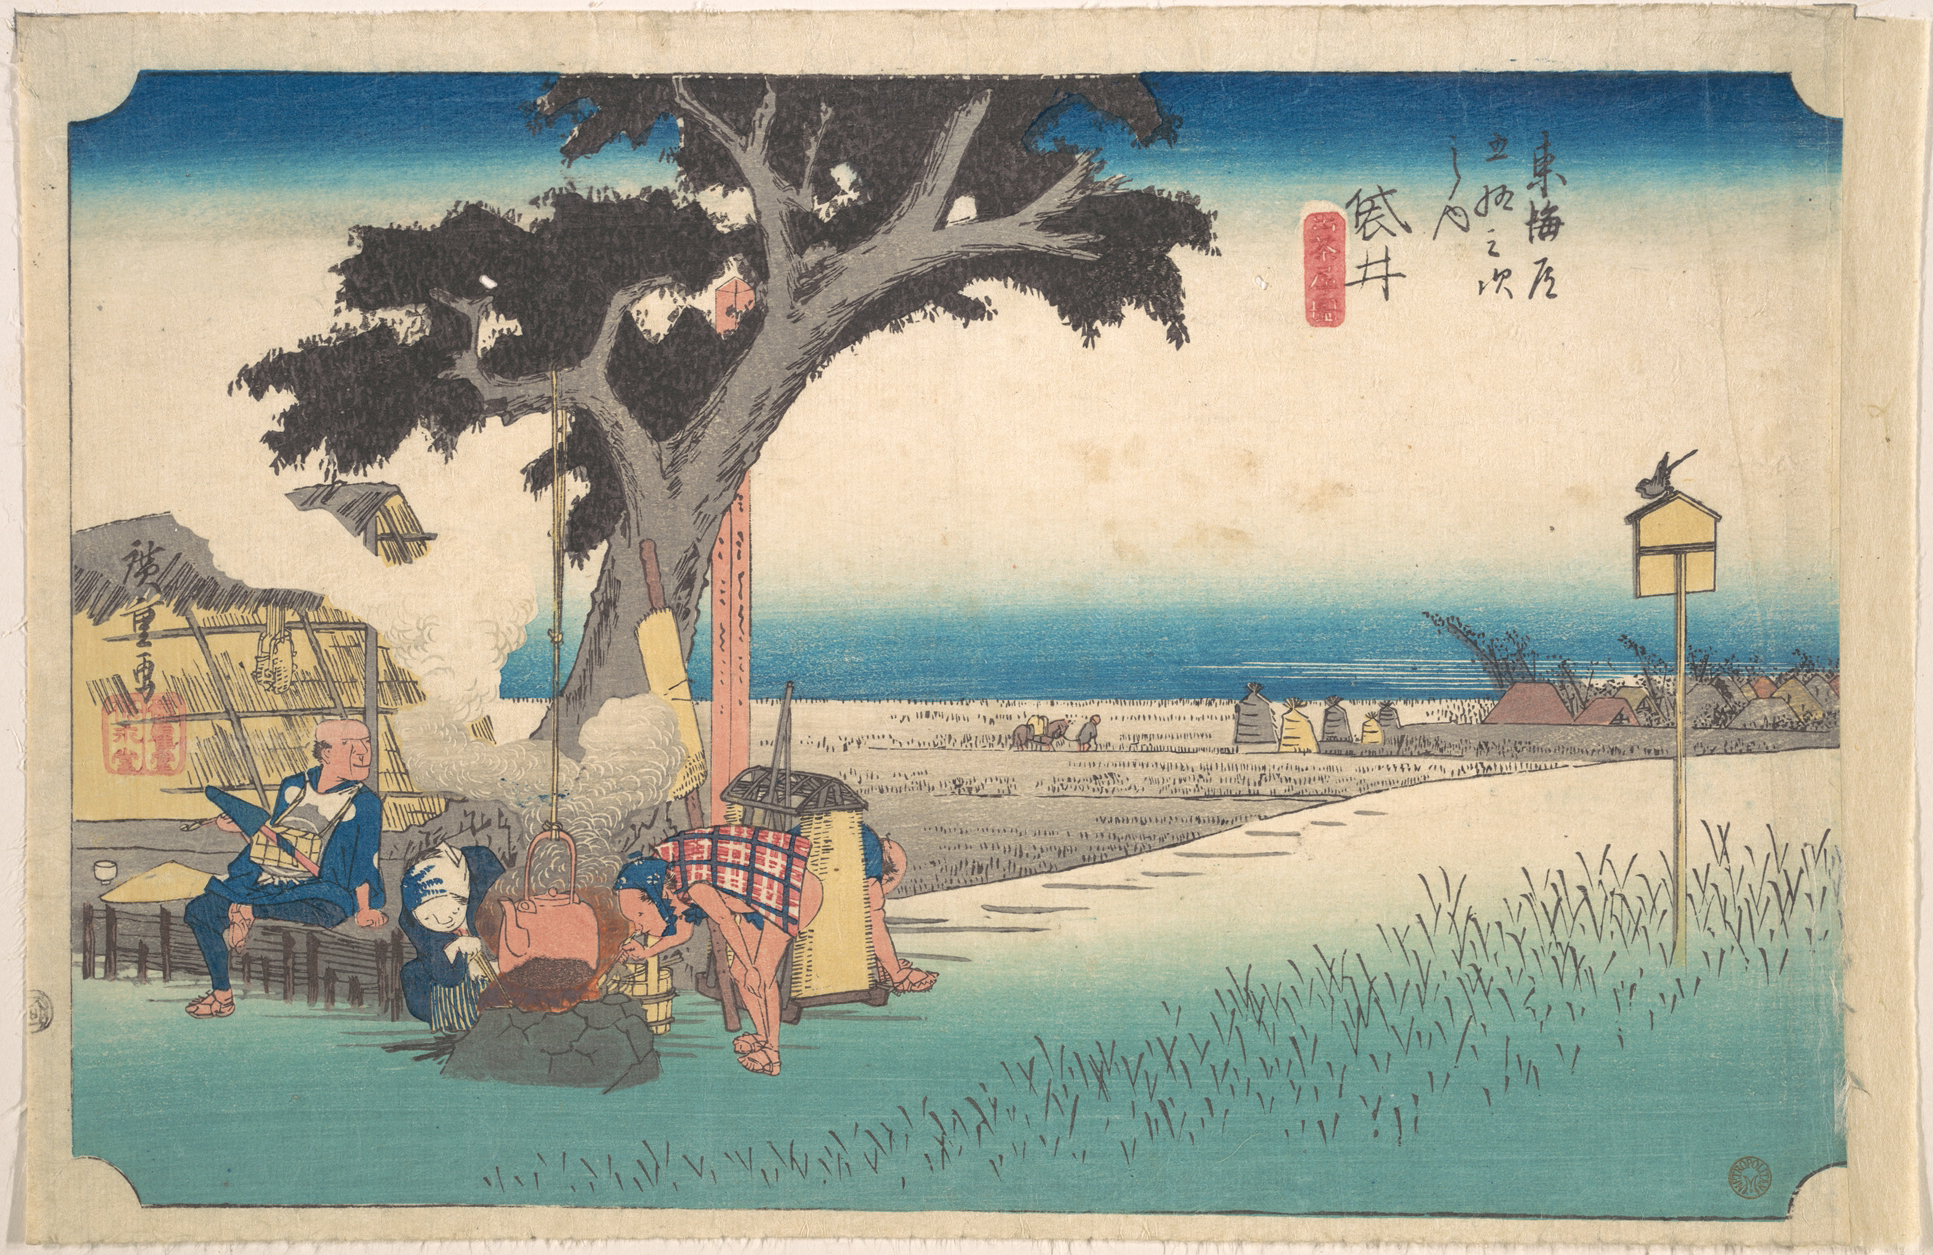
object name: print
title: Fukuroi; De Chaya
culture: japanese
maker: utagawa hiroshige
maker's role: artist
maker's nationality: japanese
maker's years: 1797-1858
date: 1834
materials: ink, paper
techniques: woodblock print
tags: men,women,kettles,tea houses